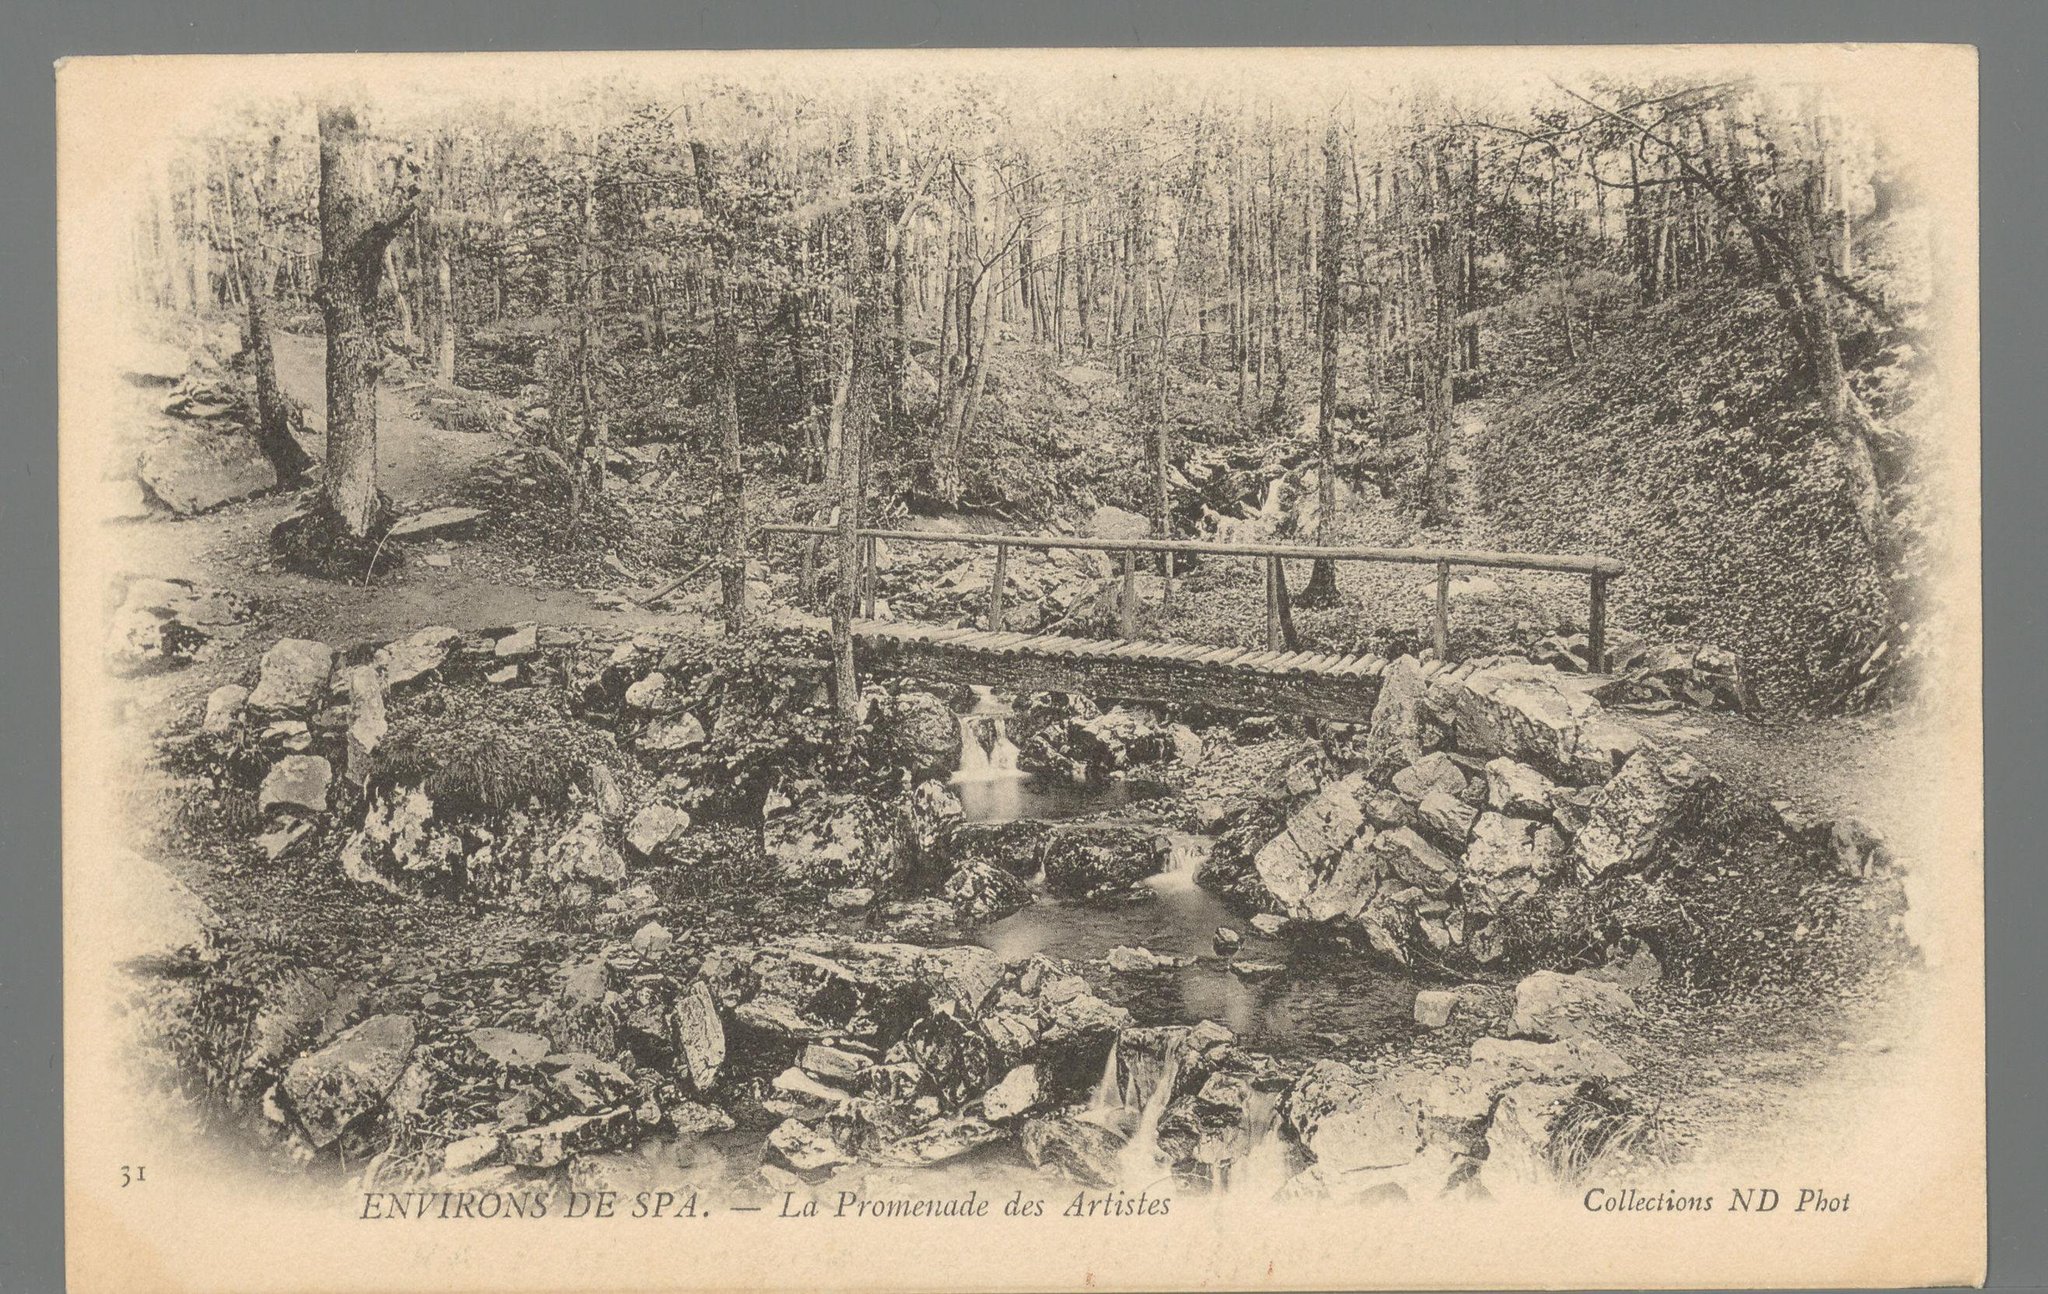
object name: photomechanical print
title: Environs de Spa. La Promenade des Artistes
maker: Anonymous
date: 1892-1906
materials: cardboard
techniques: photograph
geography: paris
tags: forest, wood, bridge